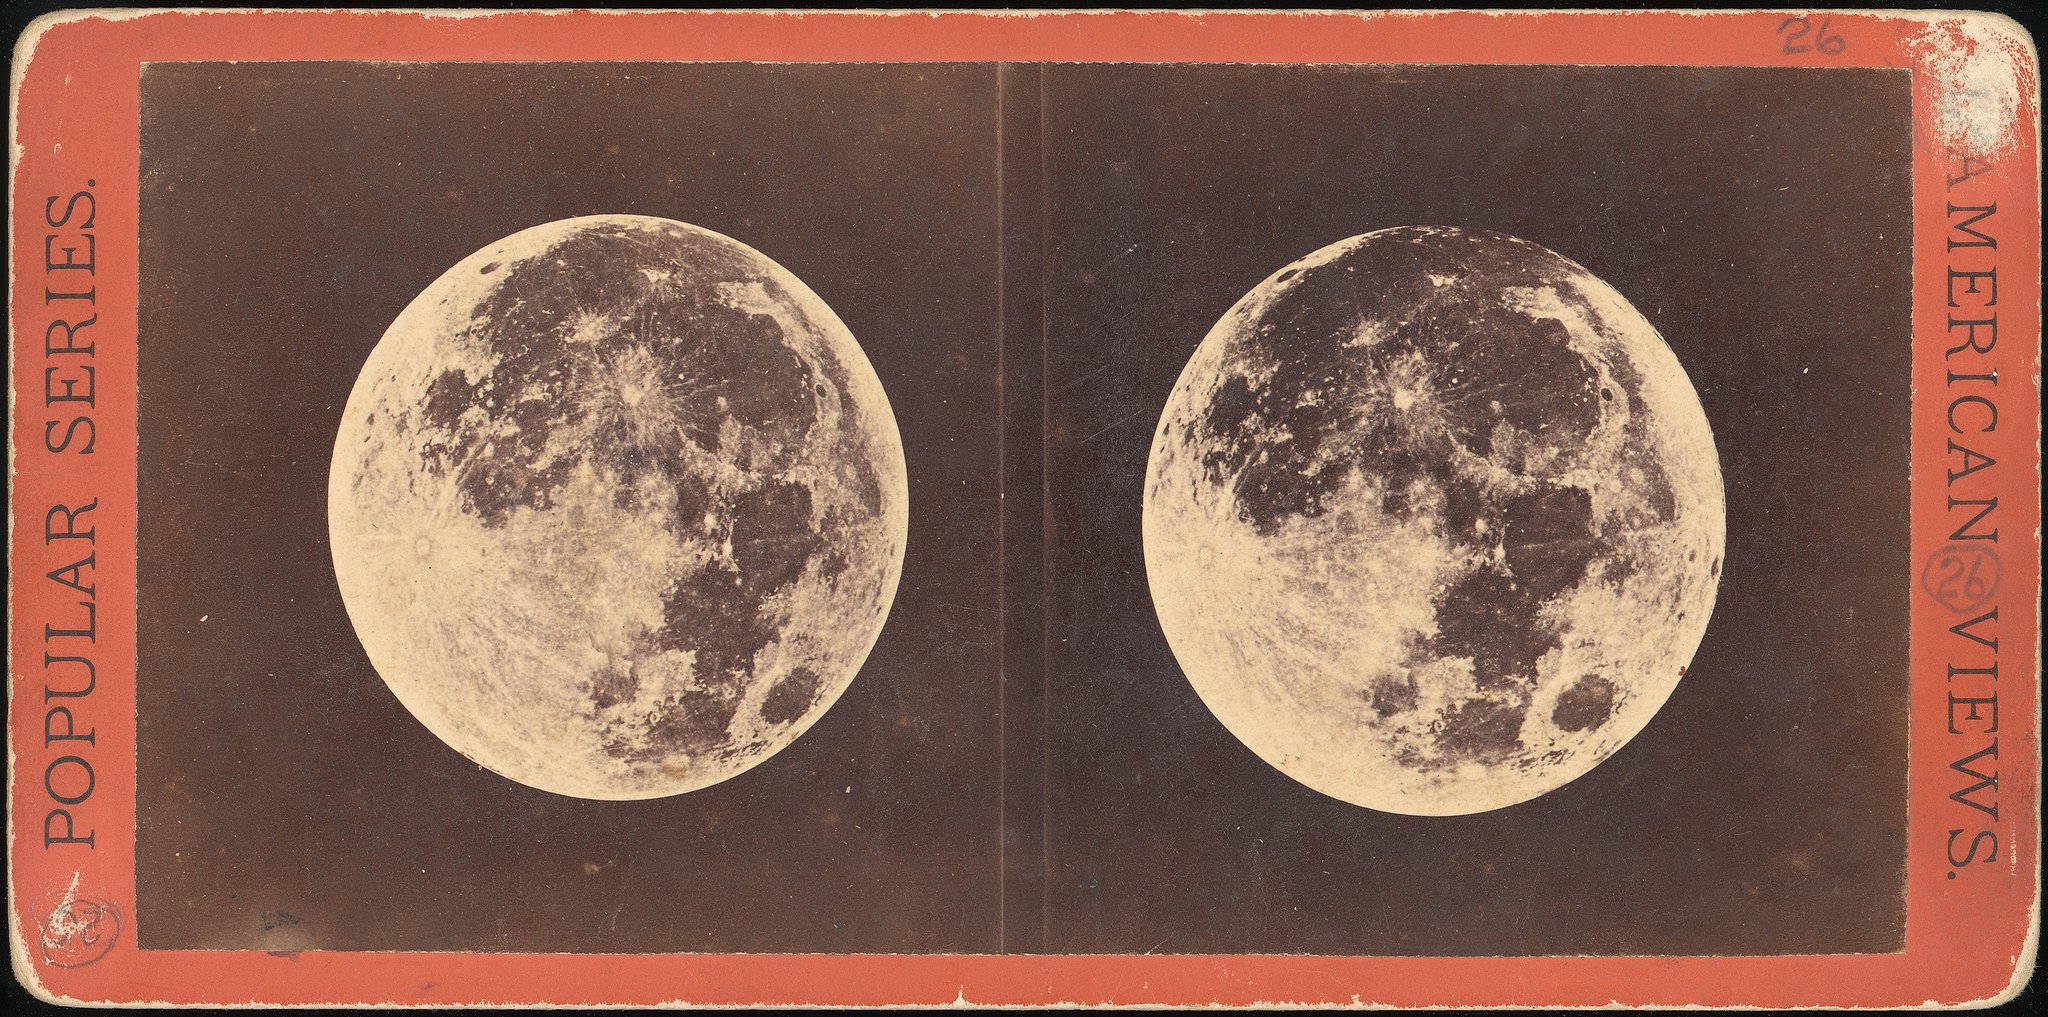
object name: stereograph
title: Full Moon: The Left Hand Moon was Photographed June 2nd, 1871. The Right Hand Moon was Photographed Aug. 29, 1871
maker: lewis morris rutherfurd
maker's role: advocaat, astronoom, fotograaf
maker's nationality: american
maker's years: 1816-1892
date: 1871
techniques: albumen silver print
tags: moon,astronomy